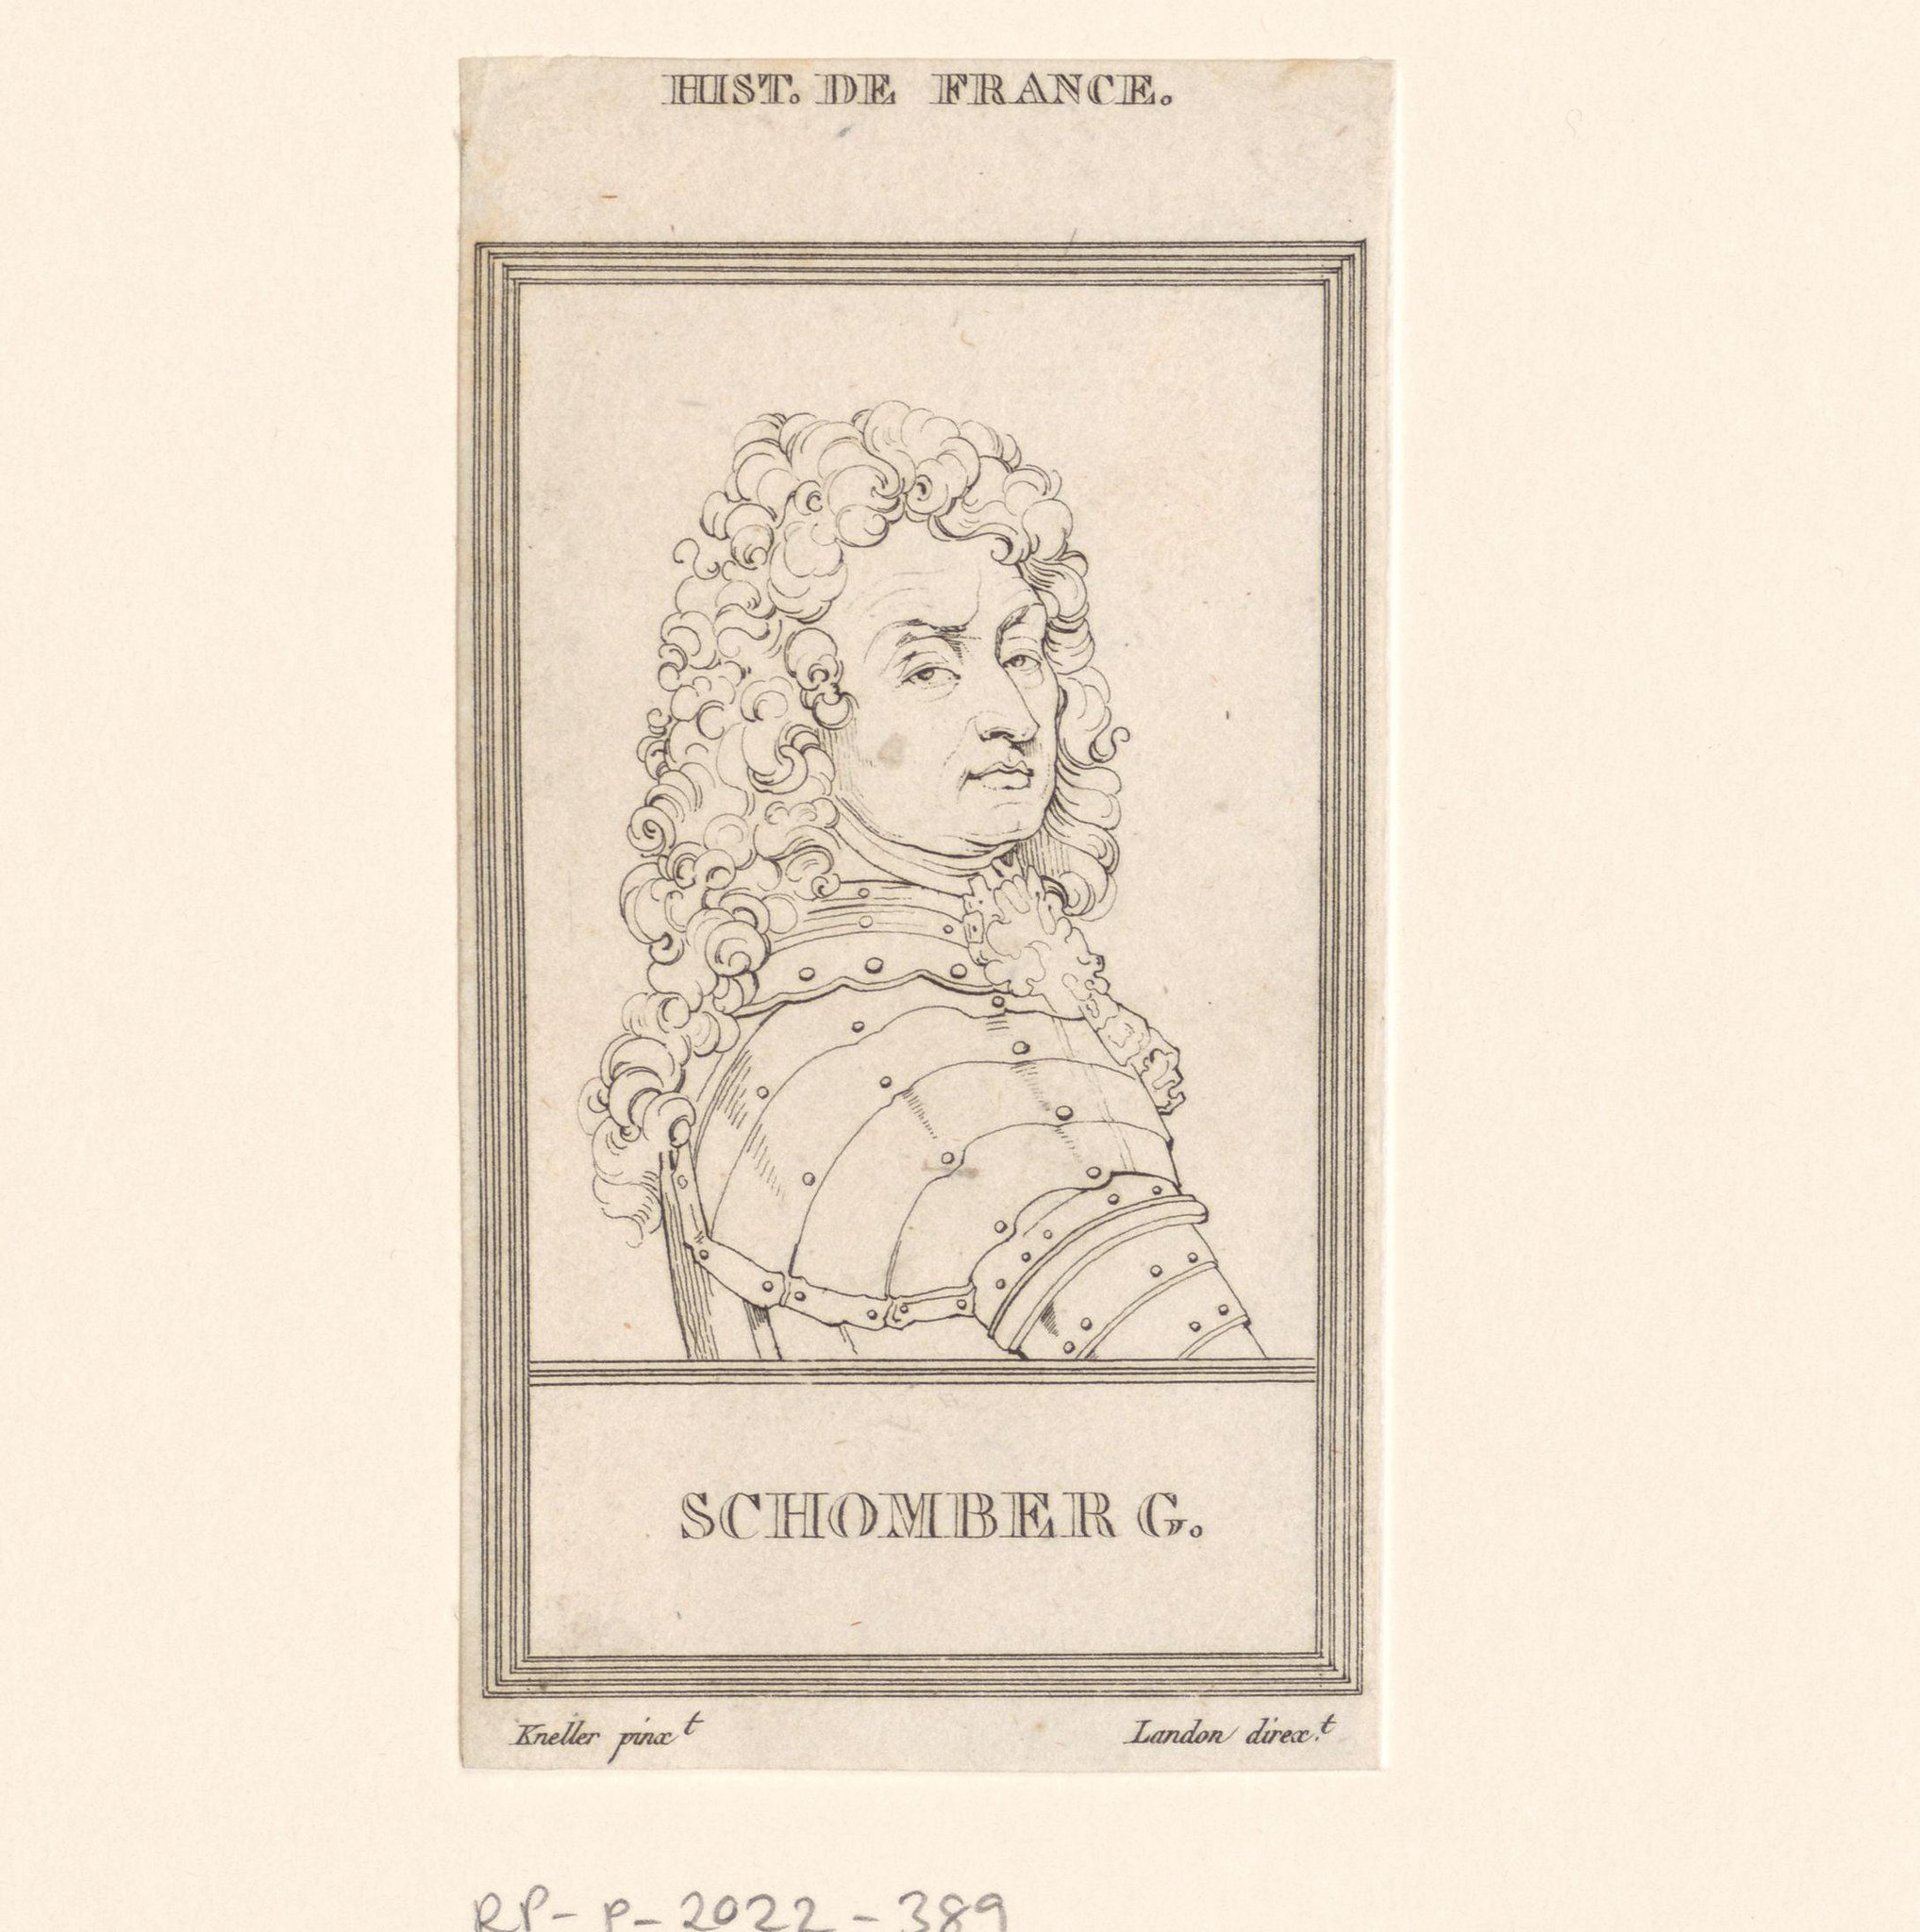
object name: print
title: Portret van hertog Frederik van Schomberg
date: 1806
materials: paper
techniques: etching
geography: paris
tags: commander-in-chief, general, marshal, historical persons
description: Prent waarschijnlijk uit: Galerie historique des hommes les plus celebres de tous les nations (...). Parijs: Charles Paul Landon, 1806, dl. 8.